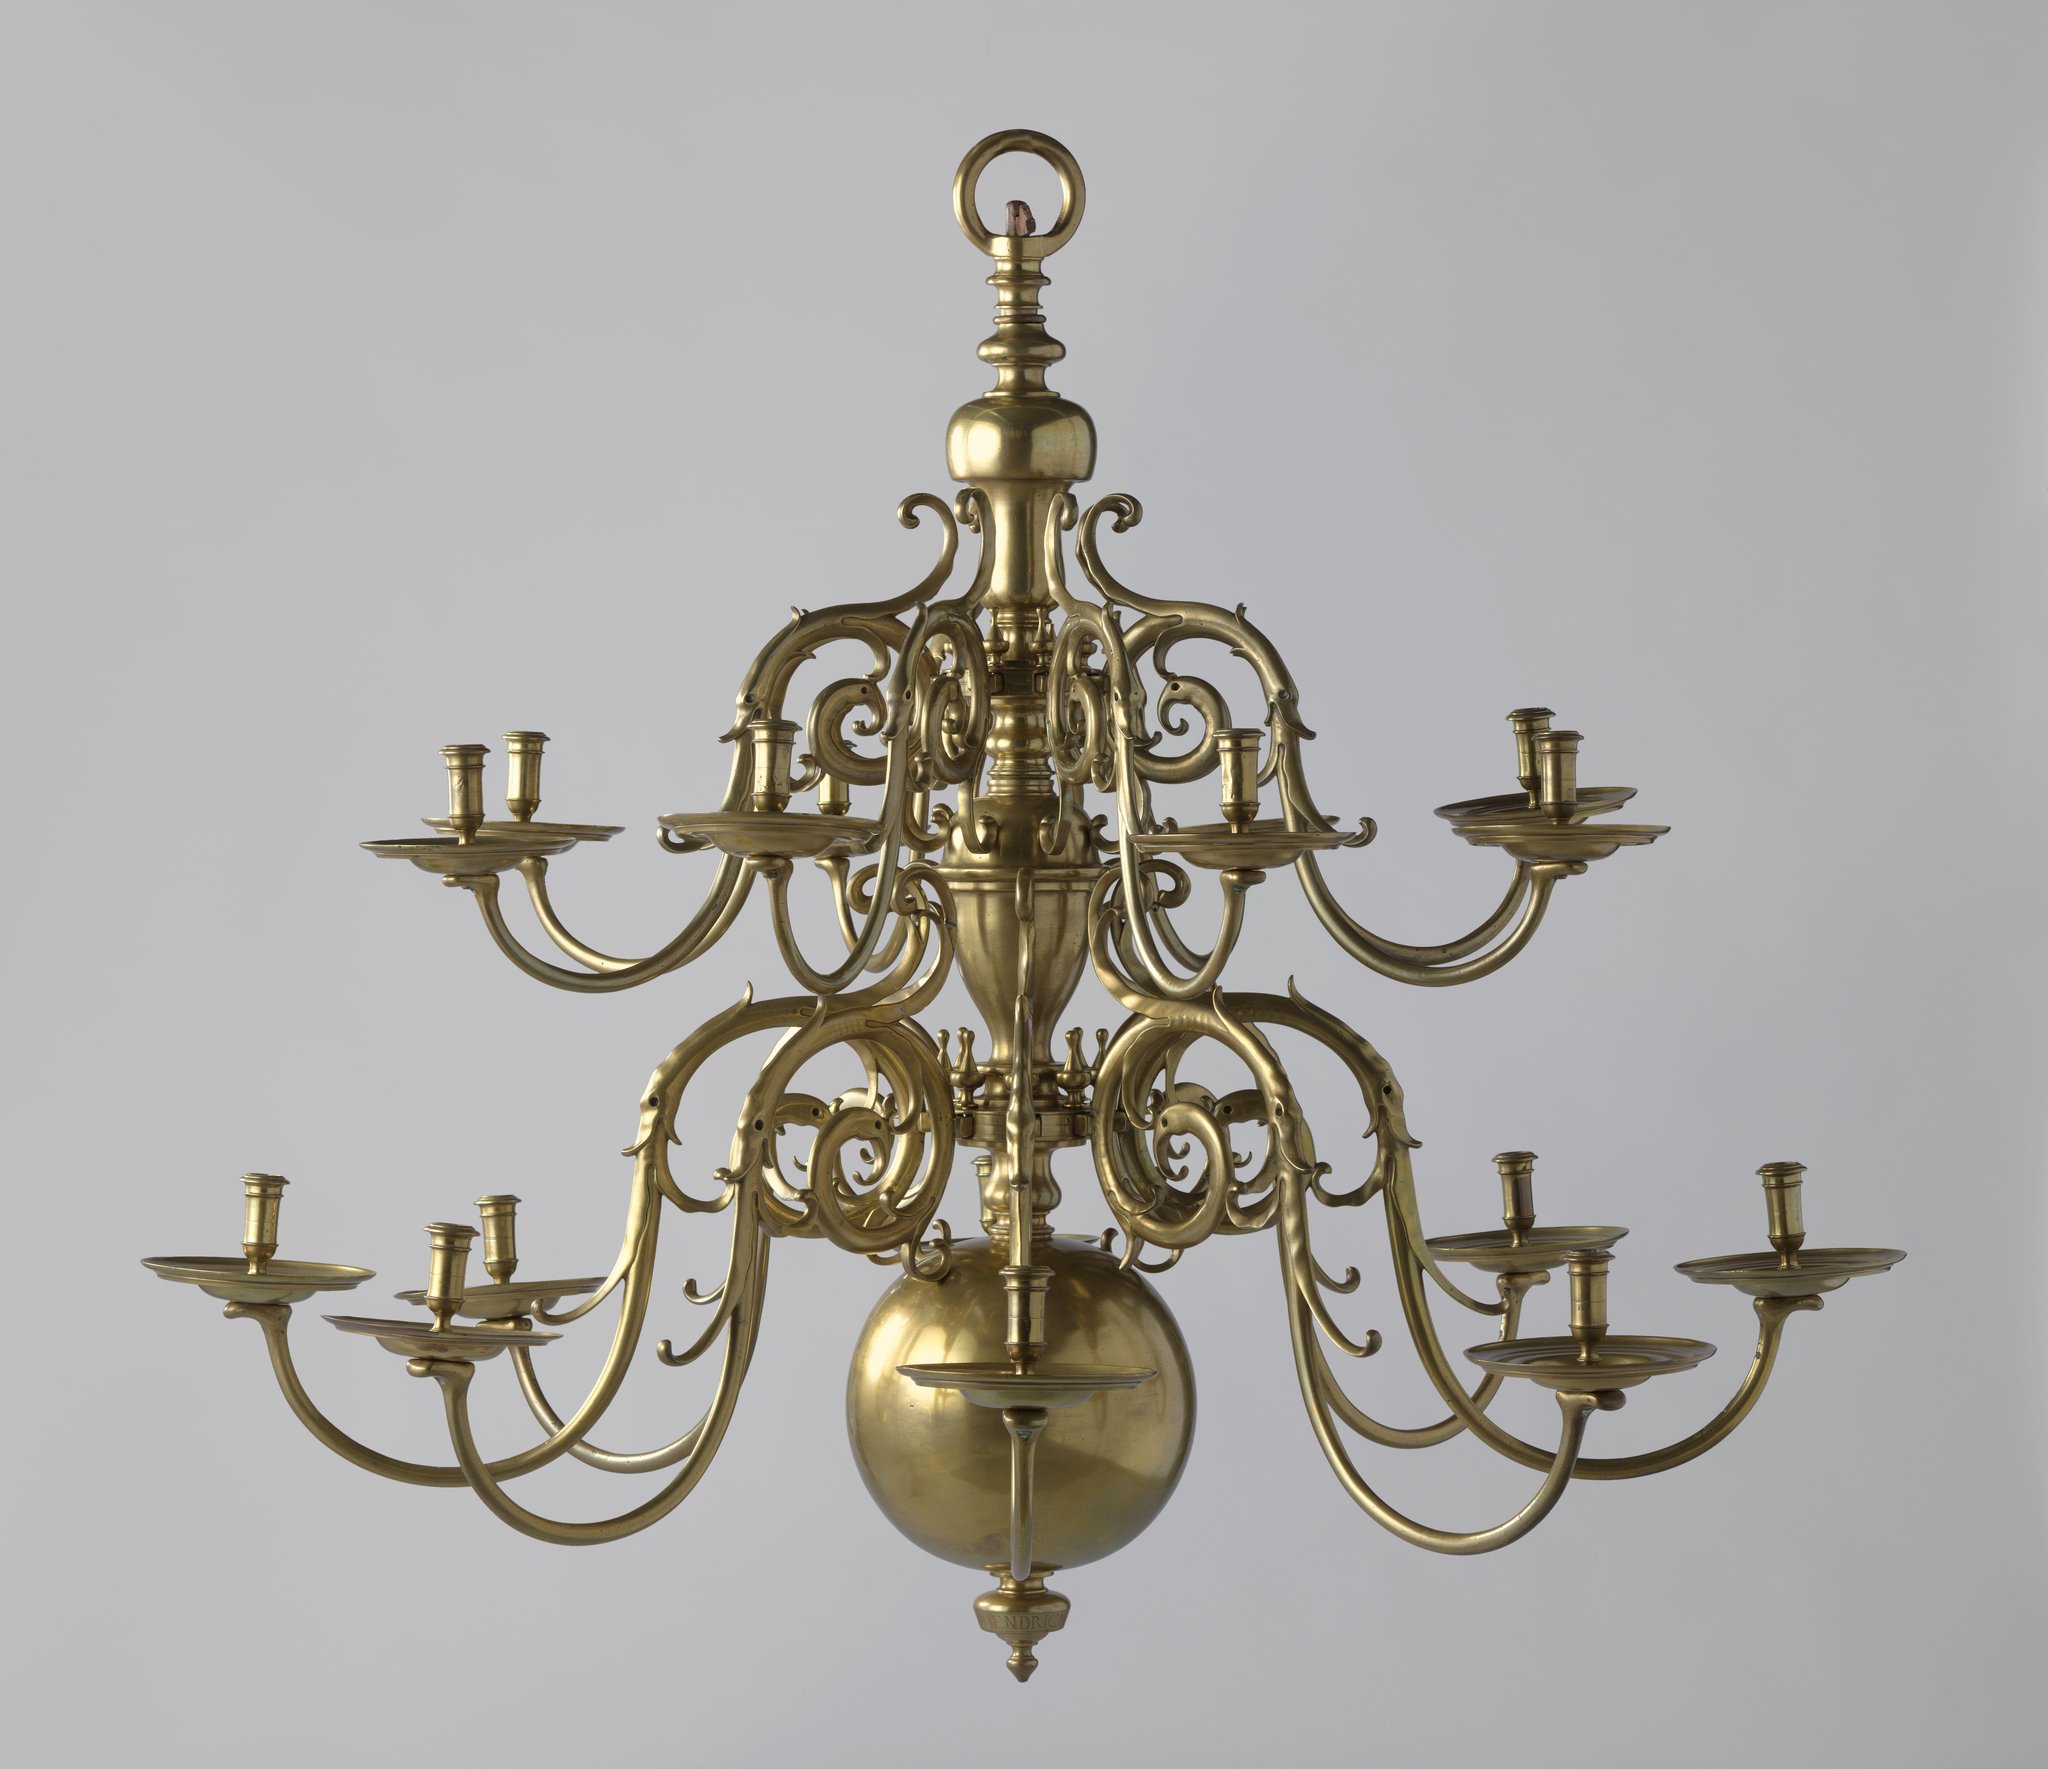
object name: chandelier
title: Arm met kaarsenhouder van kaarsenkroon van twee hoogten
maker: Anonymous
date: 1650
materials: brass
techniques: casting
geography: amsterdam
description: Kaarsenarm behorende bij een messing kaarsenkroon van twee hoogten. De S-vormige arm heeft een krul bij de aanzet, halverwege een dolfijnenkop en gaat naar buiten toe over in het platte verdikking met een schroefgat. Daarin is de kaarsenhouder met de vetvanger vastgezet. De vetvanger is aan de onderzijde geribd geprofileerd rond de opening en heeft een naar onder en een iets uitstekend randje. De cylindrische kaarsenhouder heeft een geprofileerde en een uitstekende rand, twee gegroefde ringen, een rib en een geprofileerd smaller onderstuk, dat overgaat in een uitsteeksel met een schroefdraad met een centergat. De pin om de arm te bevestigen is kegelvormig met een ronde knop bovenop. De vetvanger heeft een dichtgemaakt, rond gat, dat er op wijst dat de kaarsenkroon ooit geëlectrifieerd is geweest. Dit is de eerste arm van de bovenste standring, genummerd met het cijfer 1.